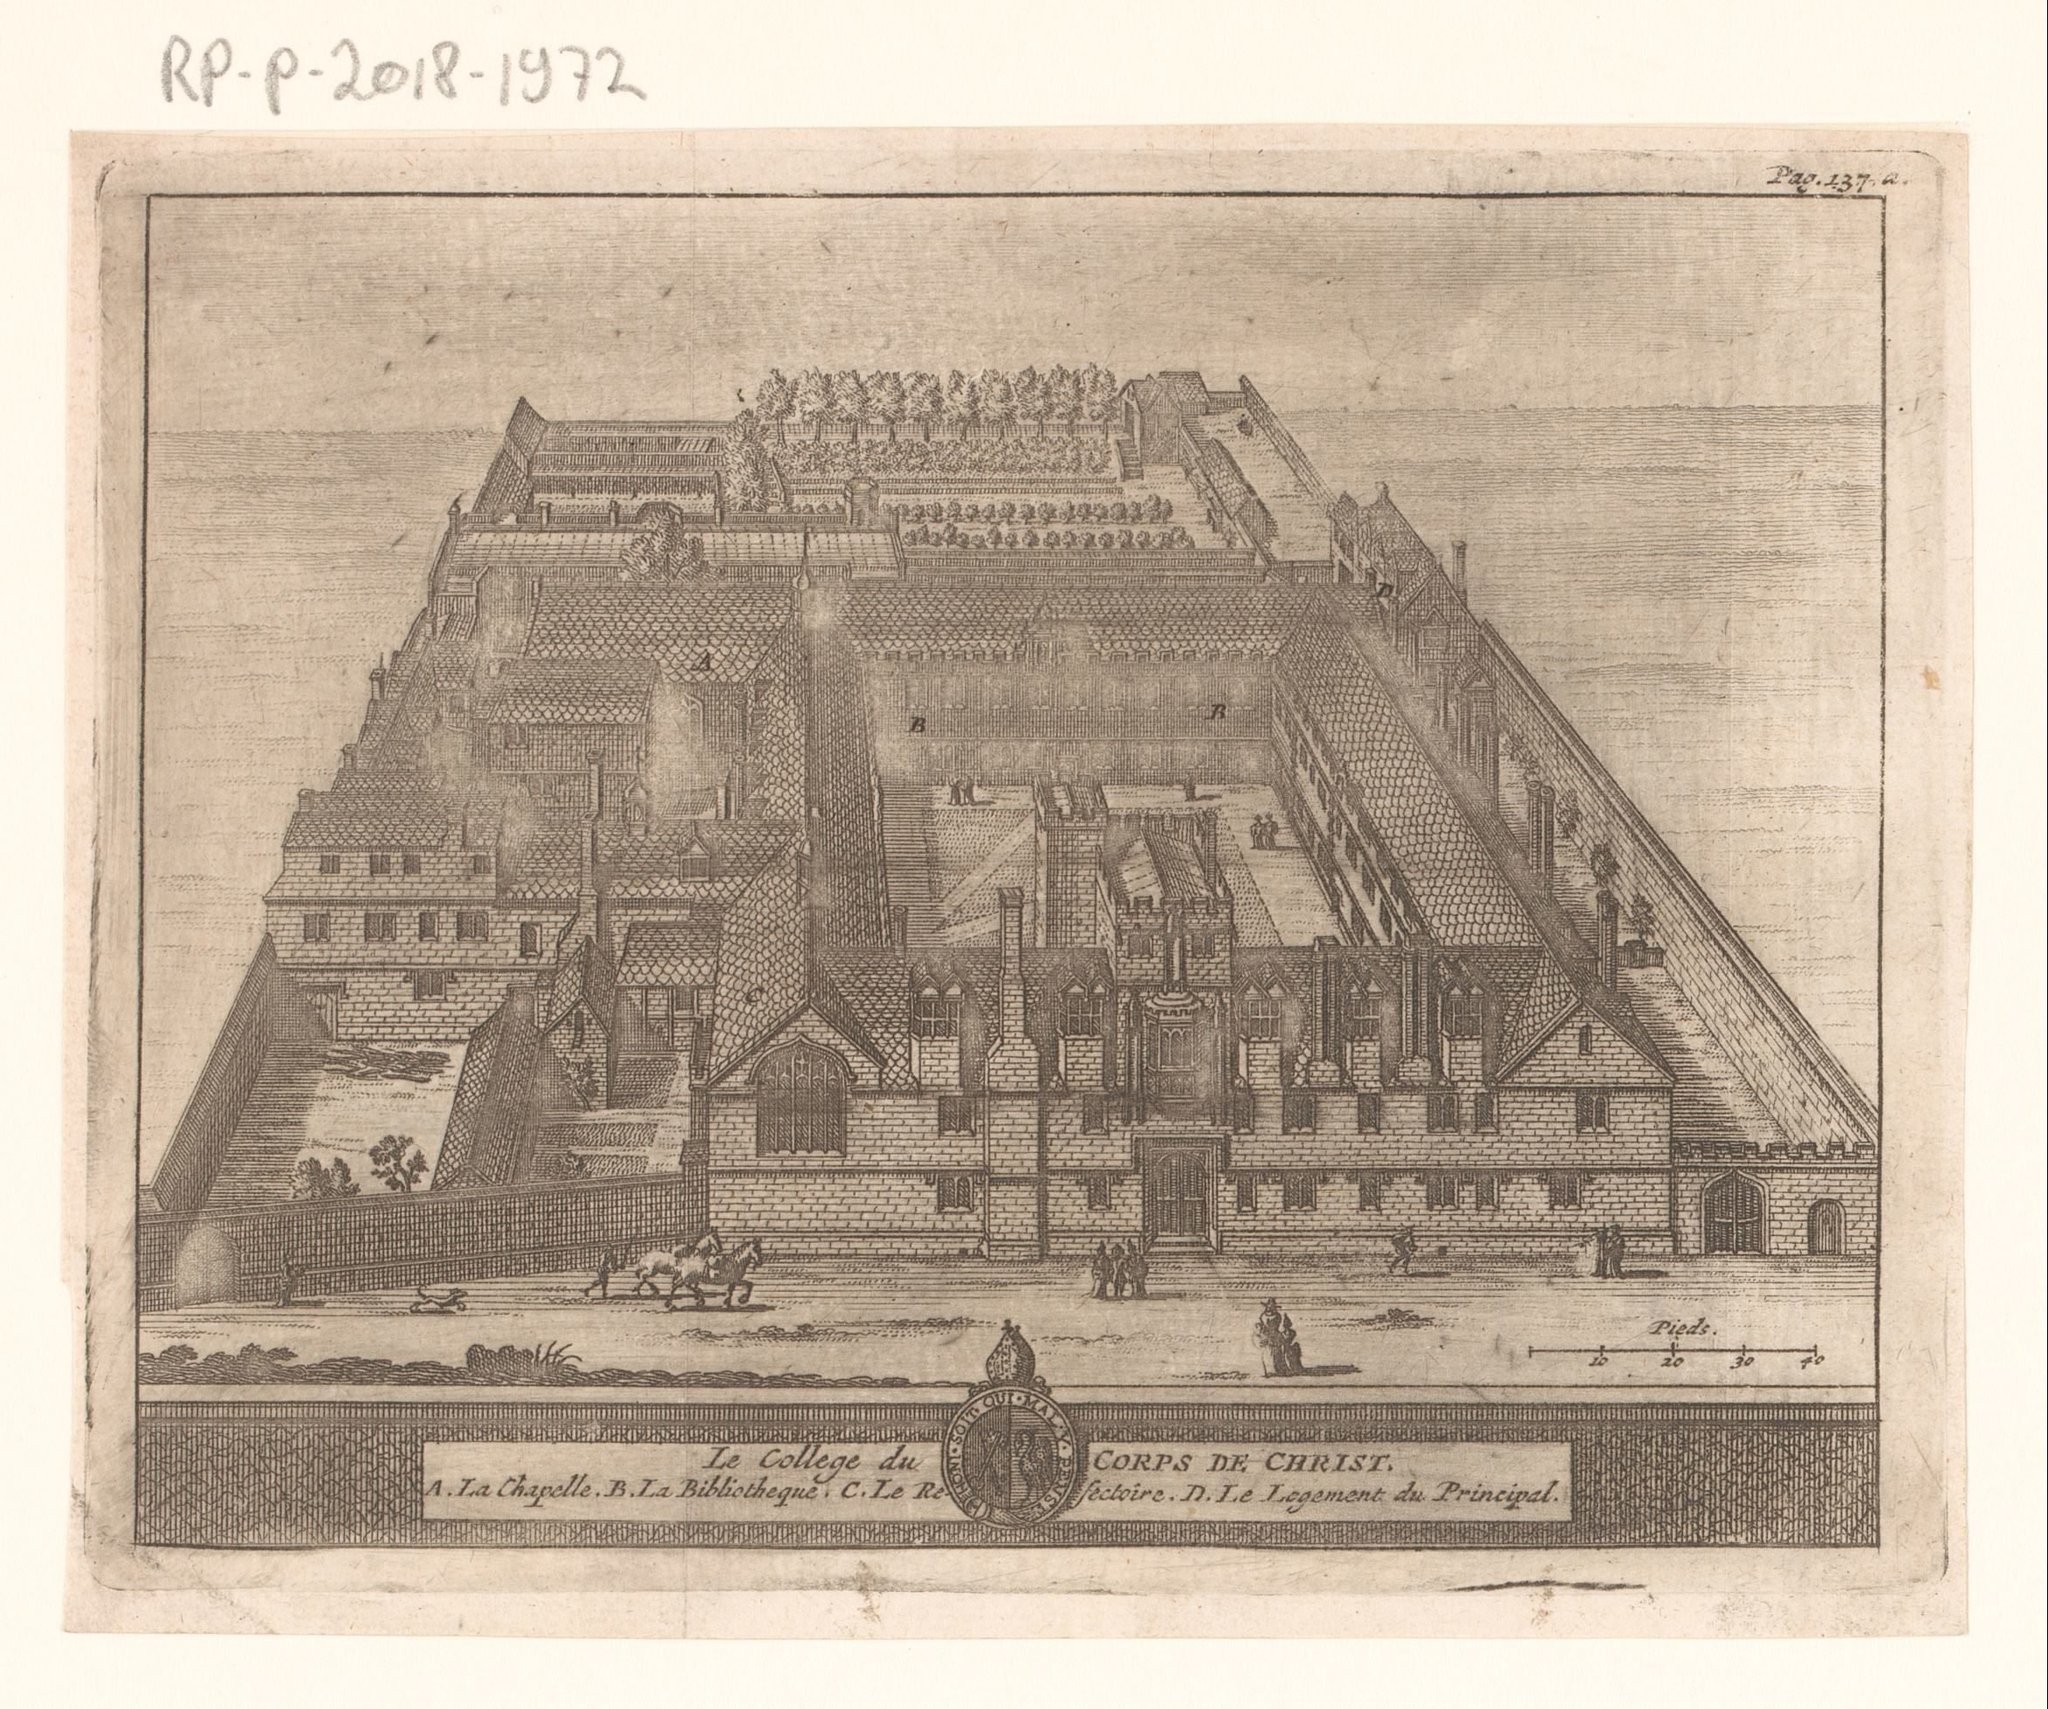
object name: print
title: Le College du Corps de Christ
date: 1707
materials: paper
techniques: etching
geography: leiden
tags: university building, college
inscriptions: collector's mark: Lugt 2228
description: Prent gebruikt in: Beeverell, James. Les Delices de la Grande Bretagne et de l'Irlande (...). Leiden: Pieter van der Aa, 1707.